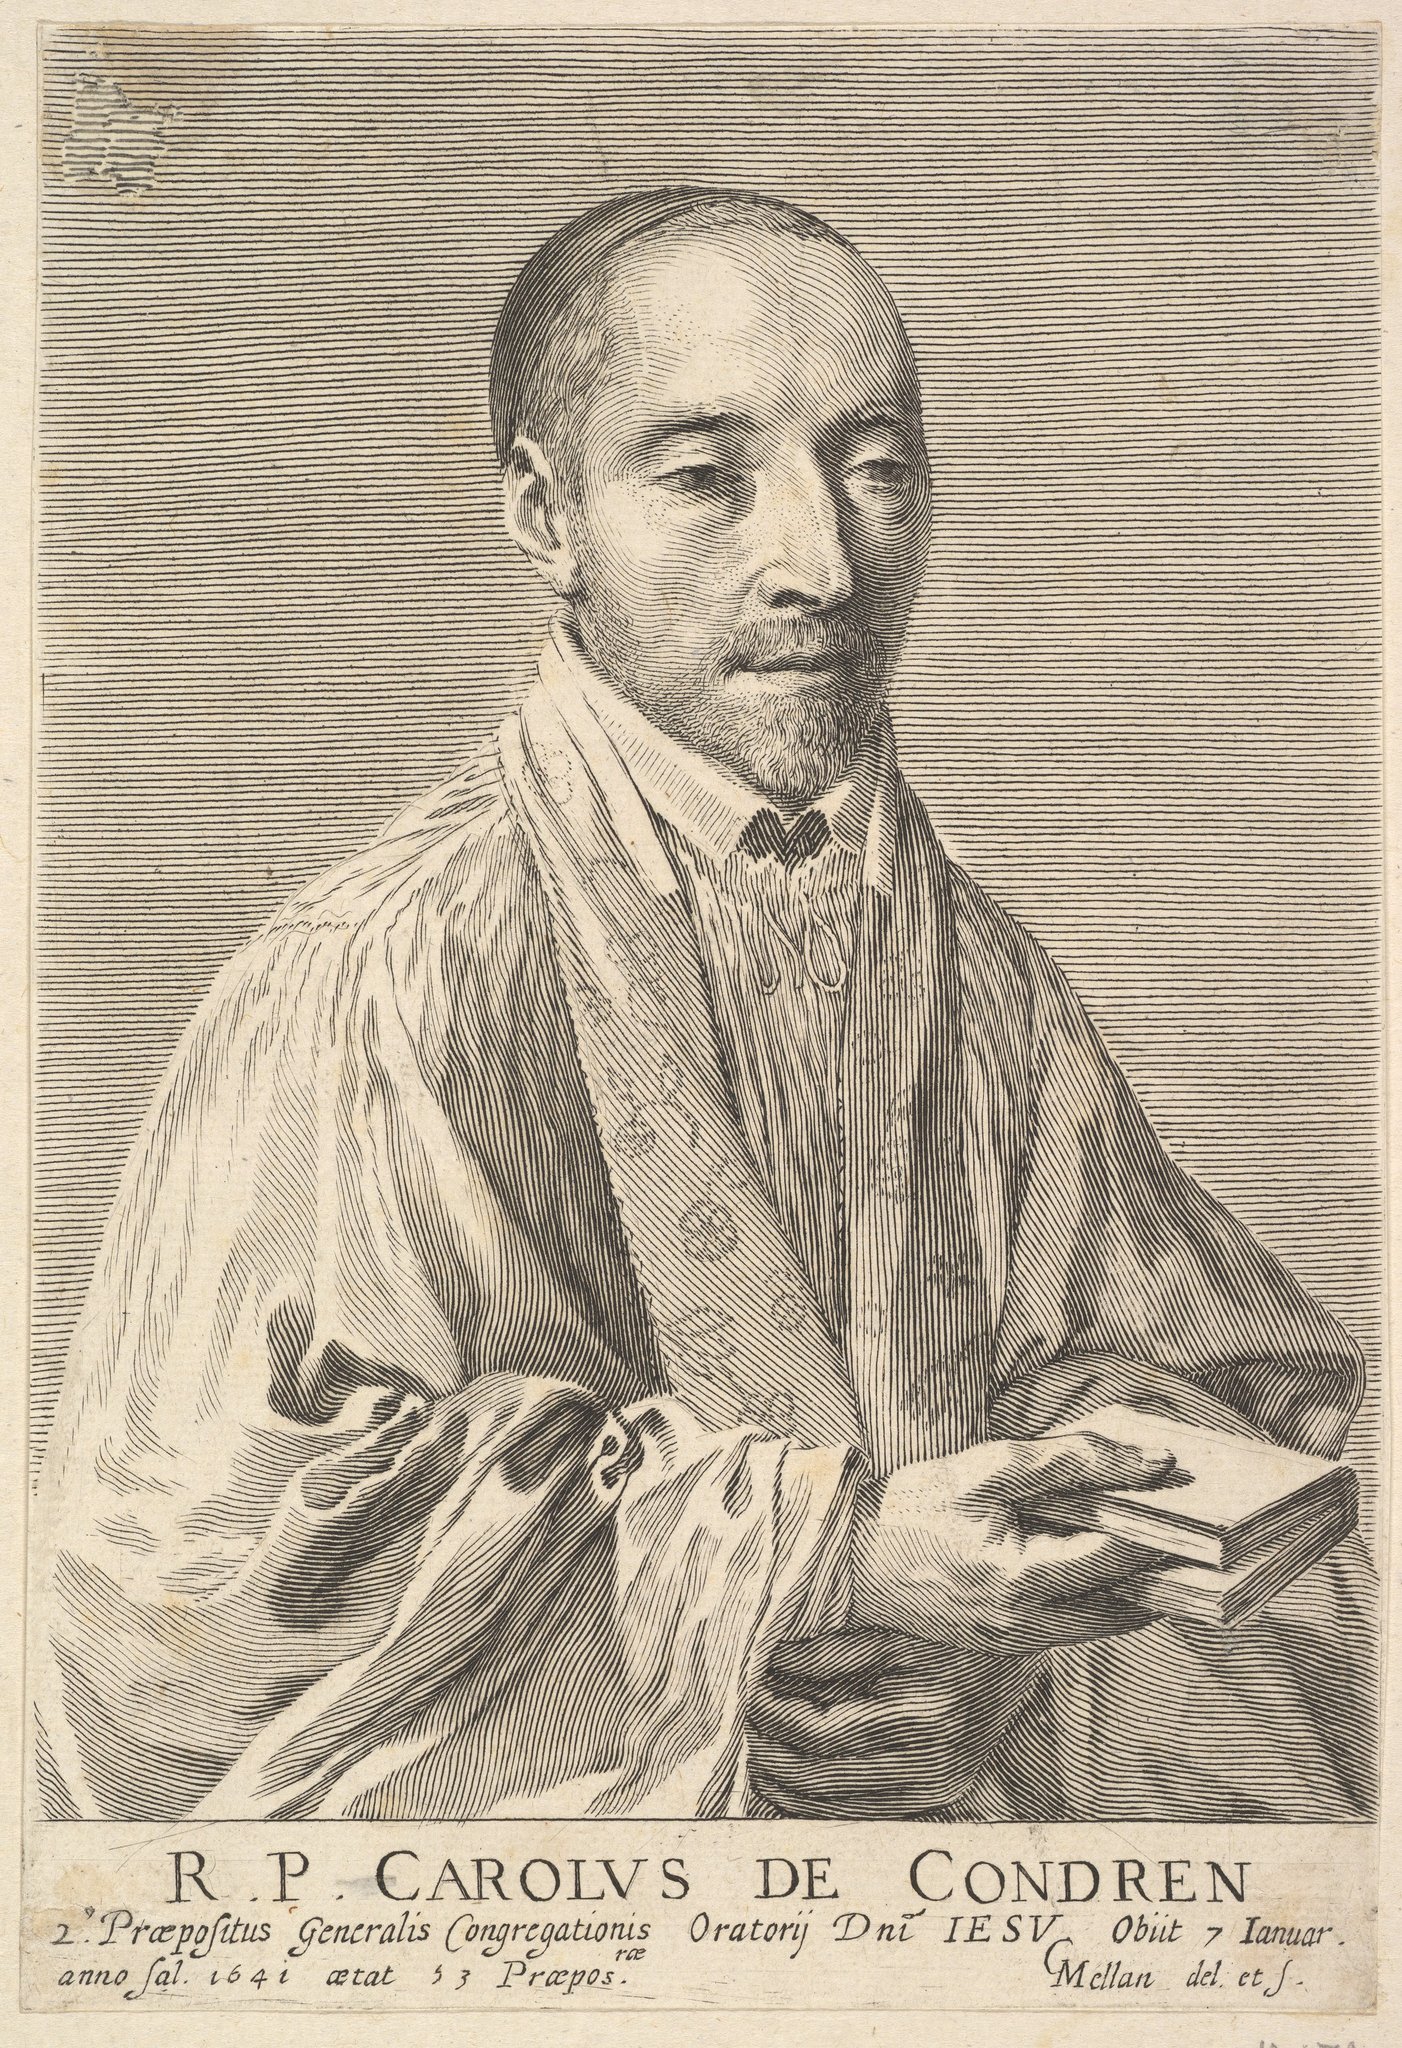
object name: print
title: Le Père Charles de Condren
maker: claude mellan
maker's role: artist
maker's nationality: french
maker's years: 1598-1688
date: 1600-1688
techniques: engraving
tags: men,portraits